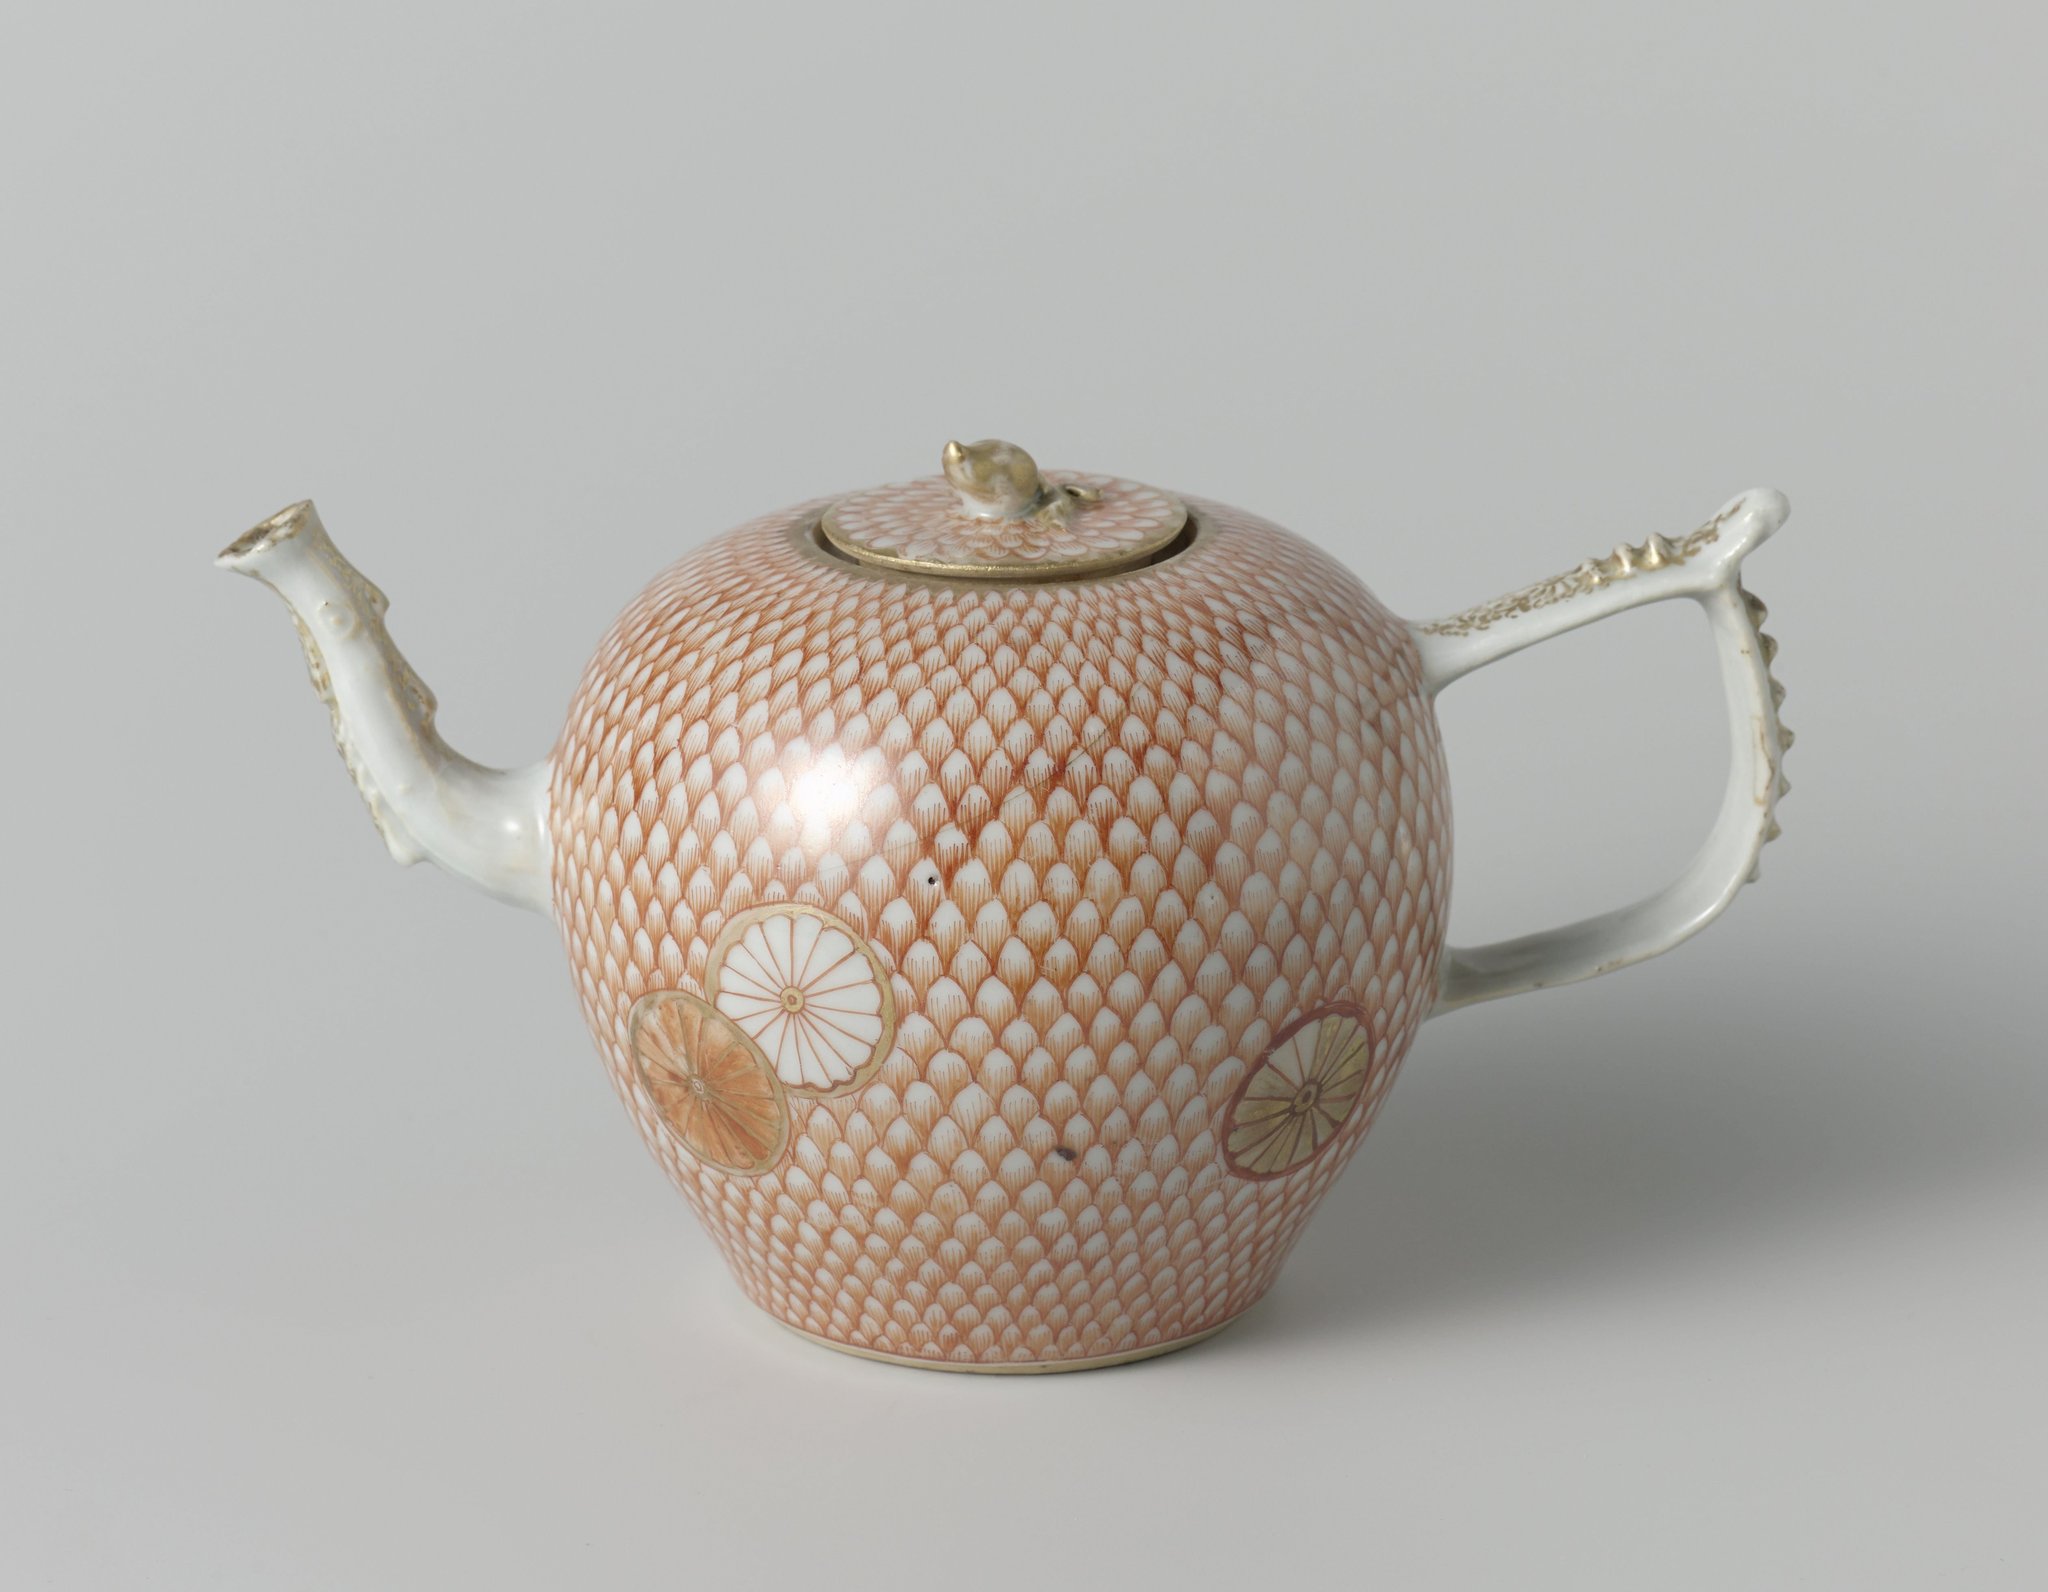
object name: teapot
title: Ovoid teapot with stylized flowers on a feather or scale ground and scrolls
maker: Anonymous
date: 1725-1749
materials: glaze, gold, paint, porcelain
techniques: firing, gilding, turning, vitrification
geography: china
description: Eivormige theepot van porselein met gebogen tuit en J-vormig oor, beschilderd op het glazuur in rood en goud. Op de buik zes gestileerde bloemen tegen een achtergrond van een veren- of schubmotief; op het oor en de tuit gemodelleerde ranken. Deksel met dezelfde decoratie. Onderdeel van een theeservies. Europese vormen met emailkleuren.